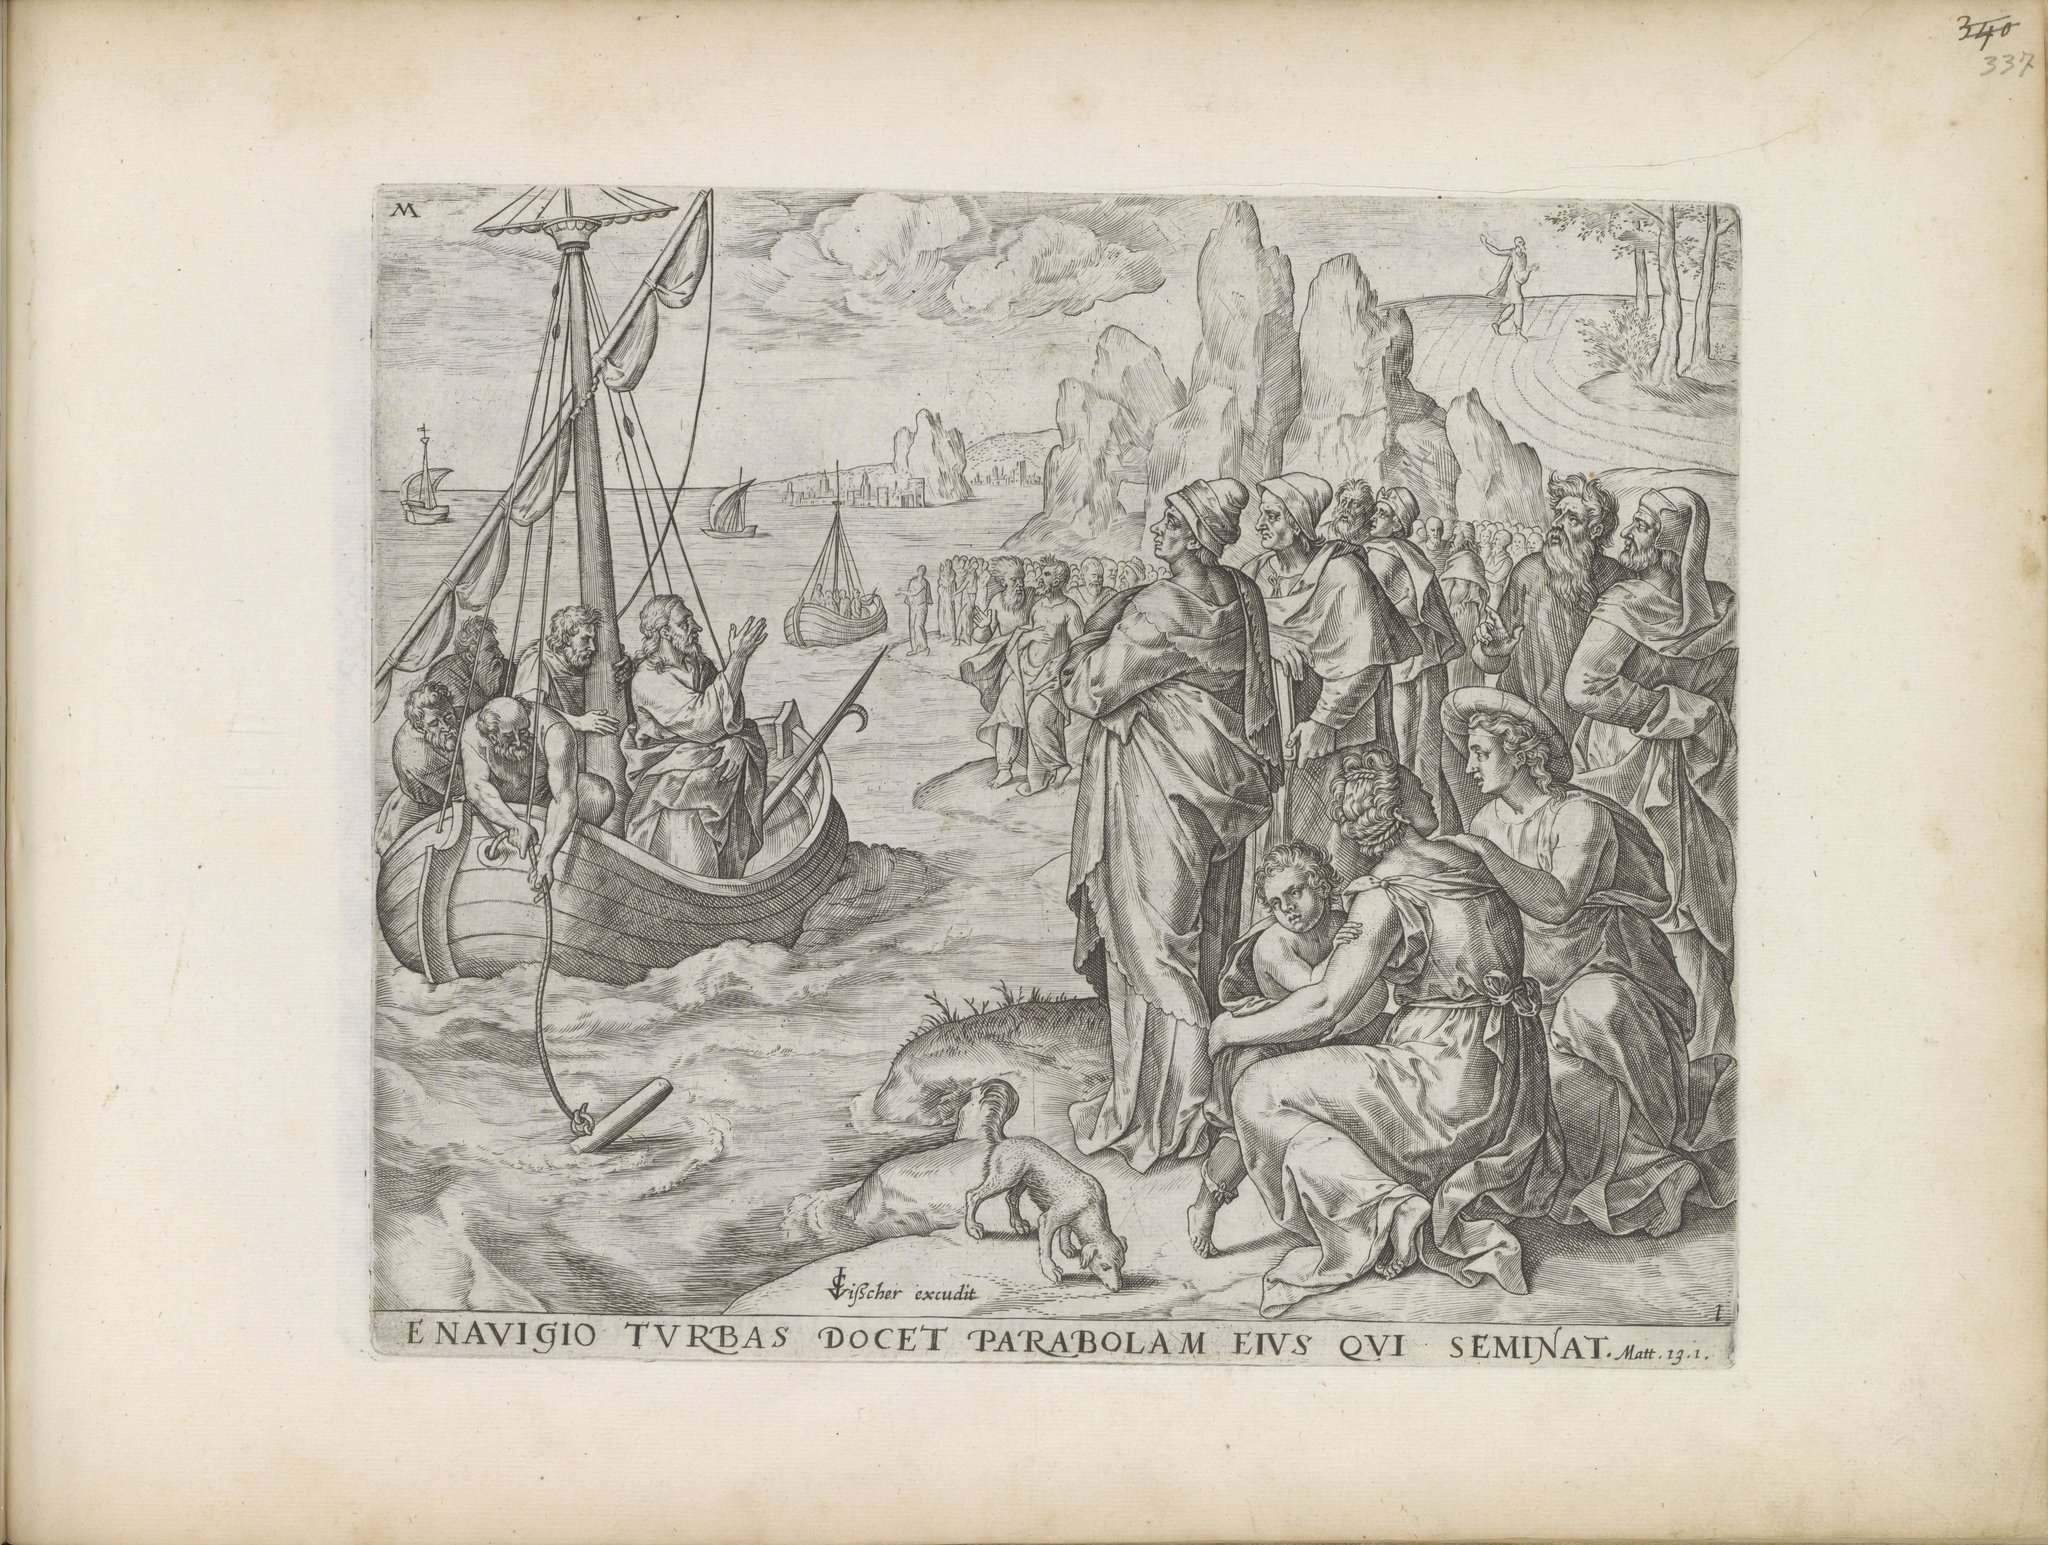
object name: print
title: Gelijkenis van de zaaier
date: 1568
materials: paper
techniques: engraving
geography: amsterdam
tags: the sower ~ parable of christ (matthew 13:3-9; mark 4:3-9; luke 8:5-8), christ preaching from a boat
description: Christus zit met vier leerlingen in een boot en vertelt de gelijkenis van de zaaier aan de menigte op de oever. Rechts op de achtergrond de zaaier, die zaad in de akker zaait. Onder de voorstelling een verwijzing in het Latijn naar de Bijbeltekst in Mat. 13:1. Deze prent maakt deel uit van een album.